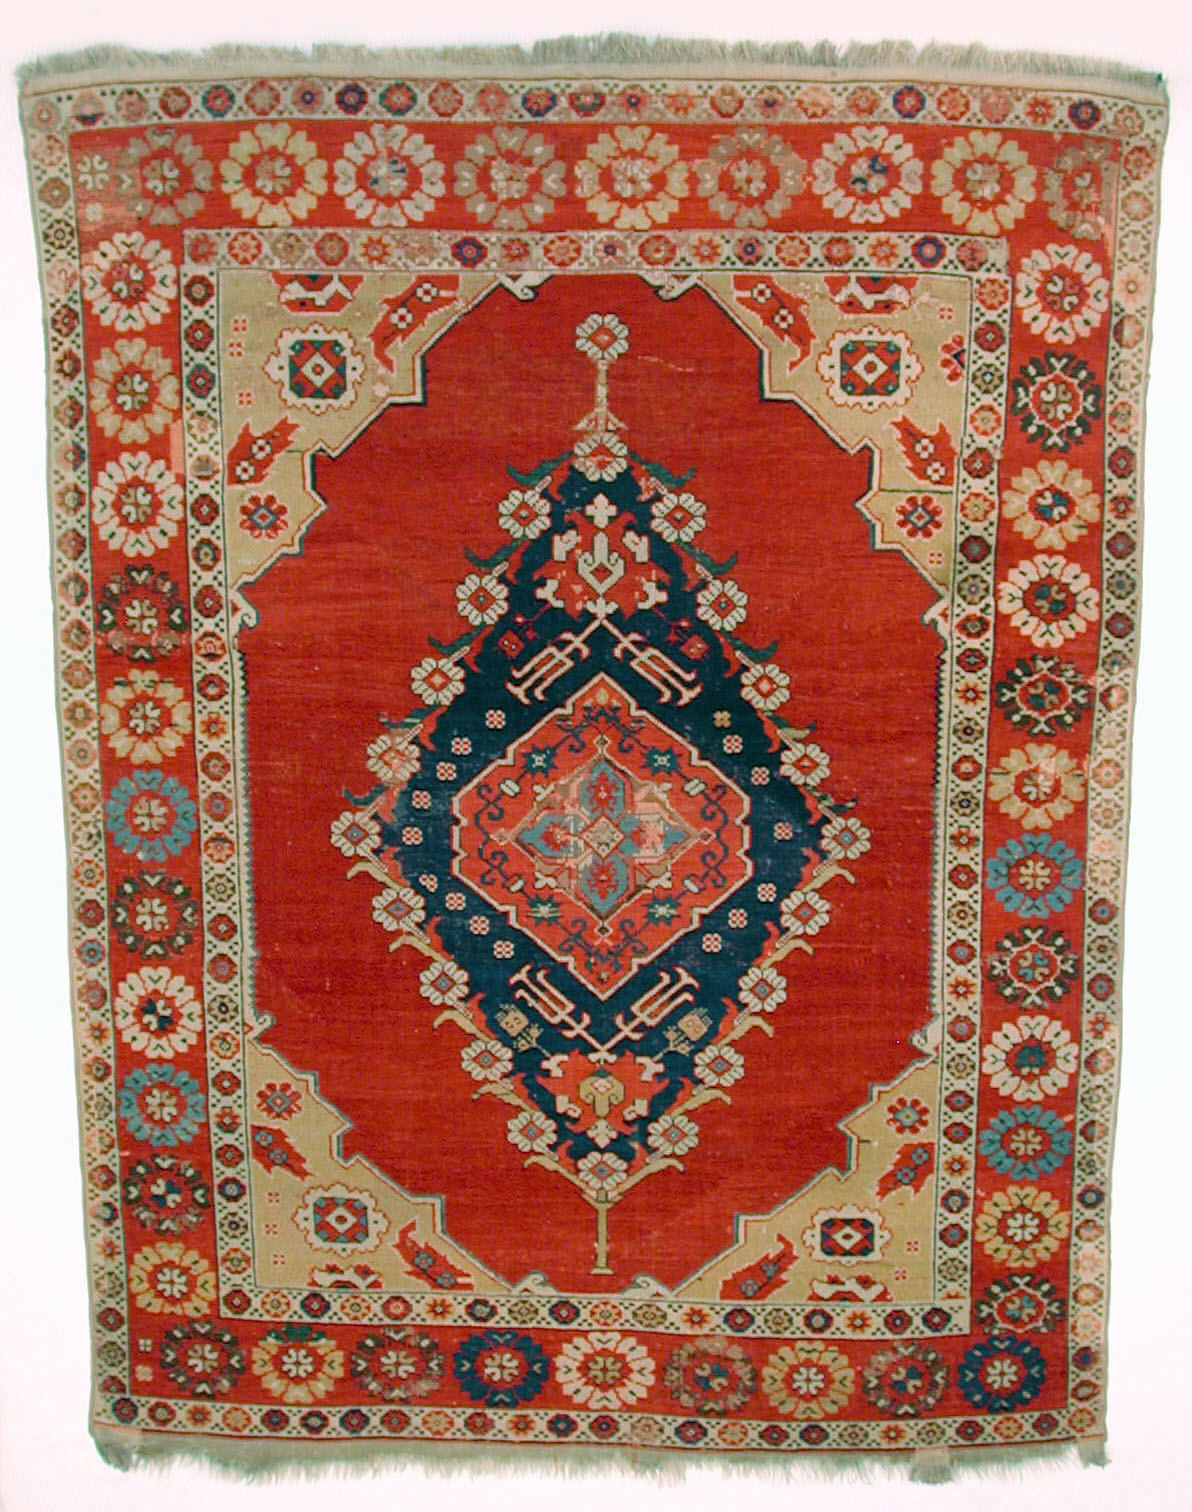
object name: carpet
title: 'Transylvanian' Carpet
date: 1701-1800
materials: wool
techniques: pile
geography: turkey